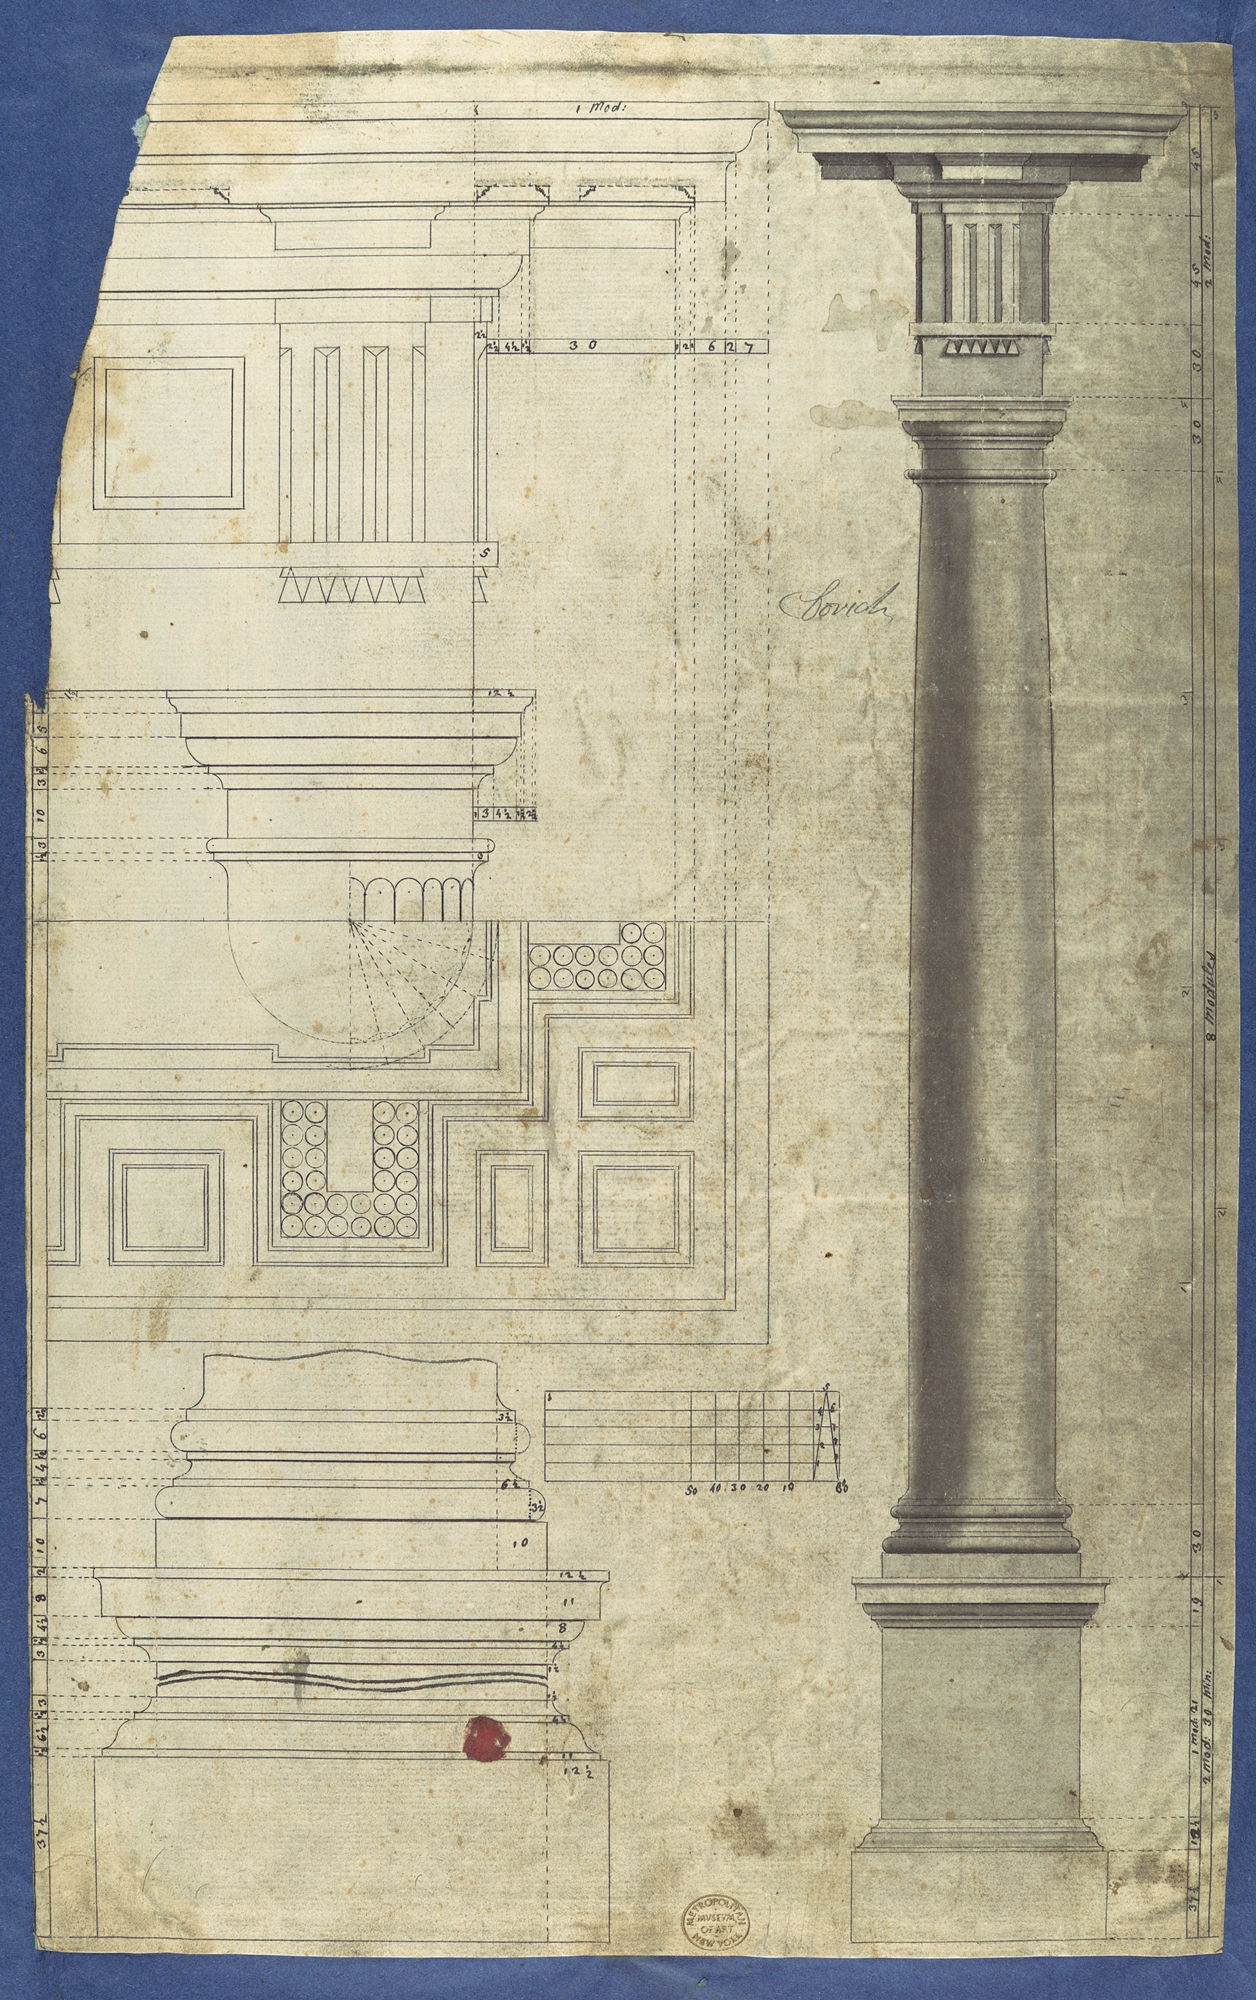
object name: drawing ornament architecture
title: The General Proportion of the Doric Order, in Chippendale Drawings, Vol. I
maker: thomas chippendale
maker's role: artist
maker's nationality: british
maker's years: 1718-1779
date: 1753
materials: ink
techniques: wash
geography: london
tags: columns